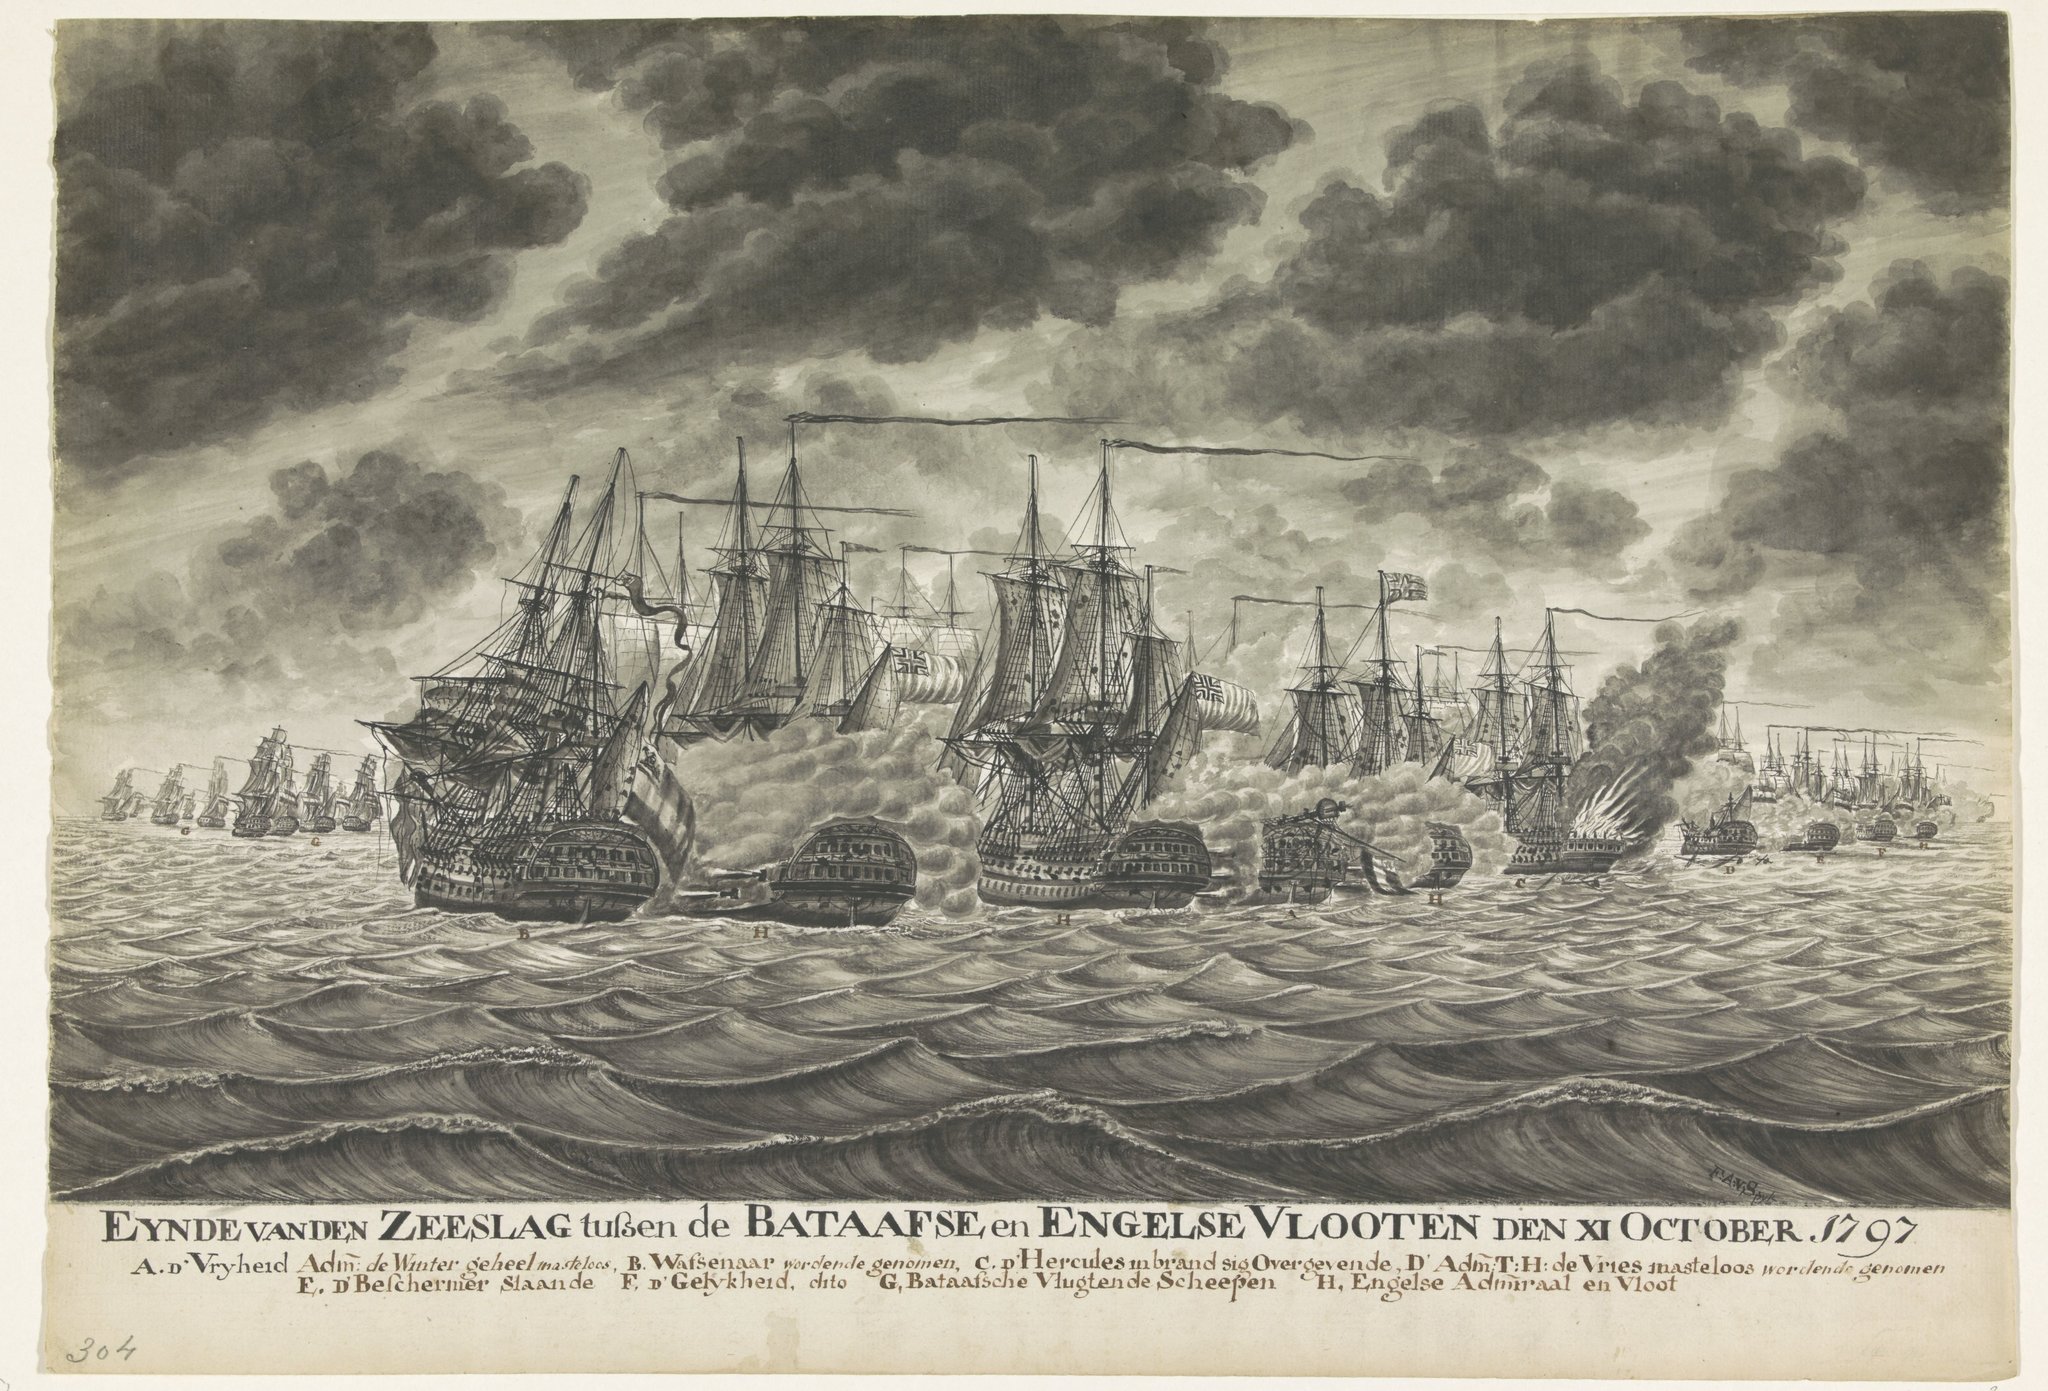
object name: drawing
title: Einde van de zeeslag bij Kamperduin, 11 oktober 1797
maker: frans anton van spijck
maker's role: print maker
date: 1797-1798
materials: paper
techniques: brush, pen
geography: netherlands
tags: jan willem de winter, battle (+ naval force), battle of camperdown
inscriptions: collector's mark: Lugt 2228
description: De Zeeslag bij Kamperduin op 11 oktober 1797 tussen de Bataafse vloot onder bevel van viceadmiraal Jan Willem de Winter en een Britse vloot onder admiraal Adam Duncan. Einde van de slag met de de Vrijheid mastloos tussen Engelse schepen, de brandende Hercules en links vluchtende Bataatse schepen. Onder zwaar bewolkte hemel. In het onderschrift een legenda A-H van Bataafse schepen. Zie pendant.